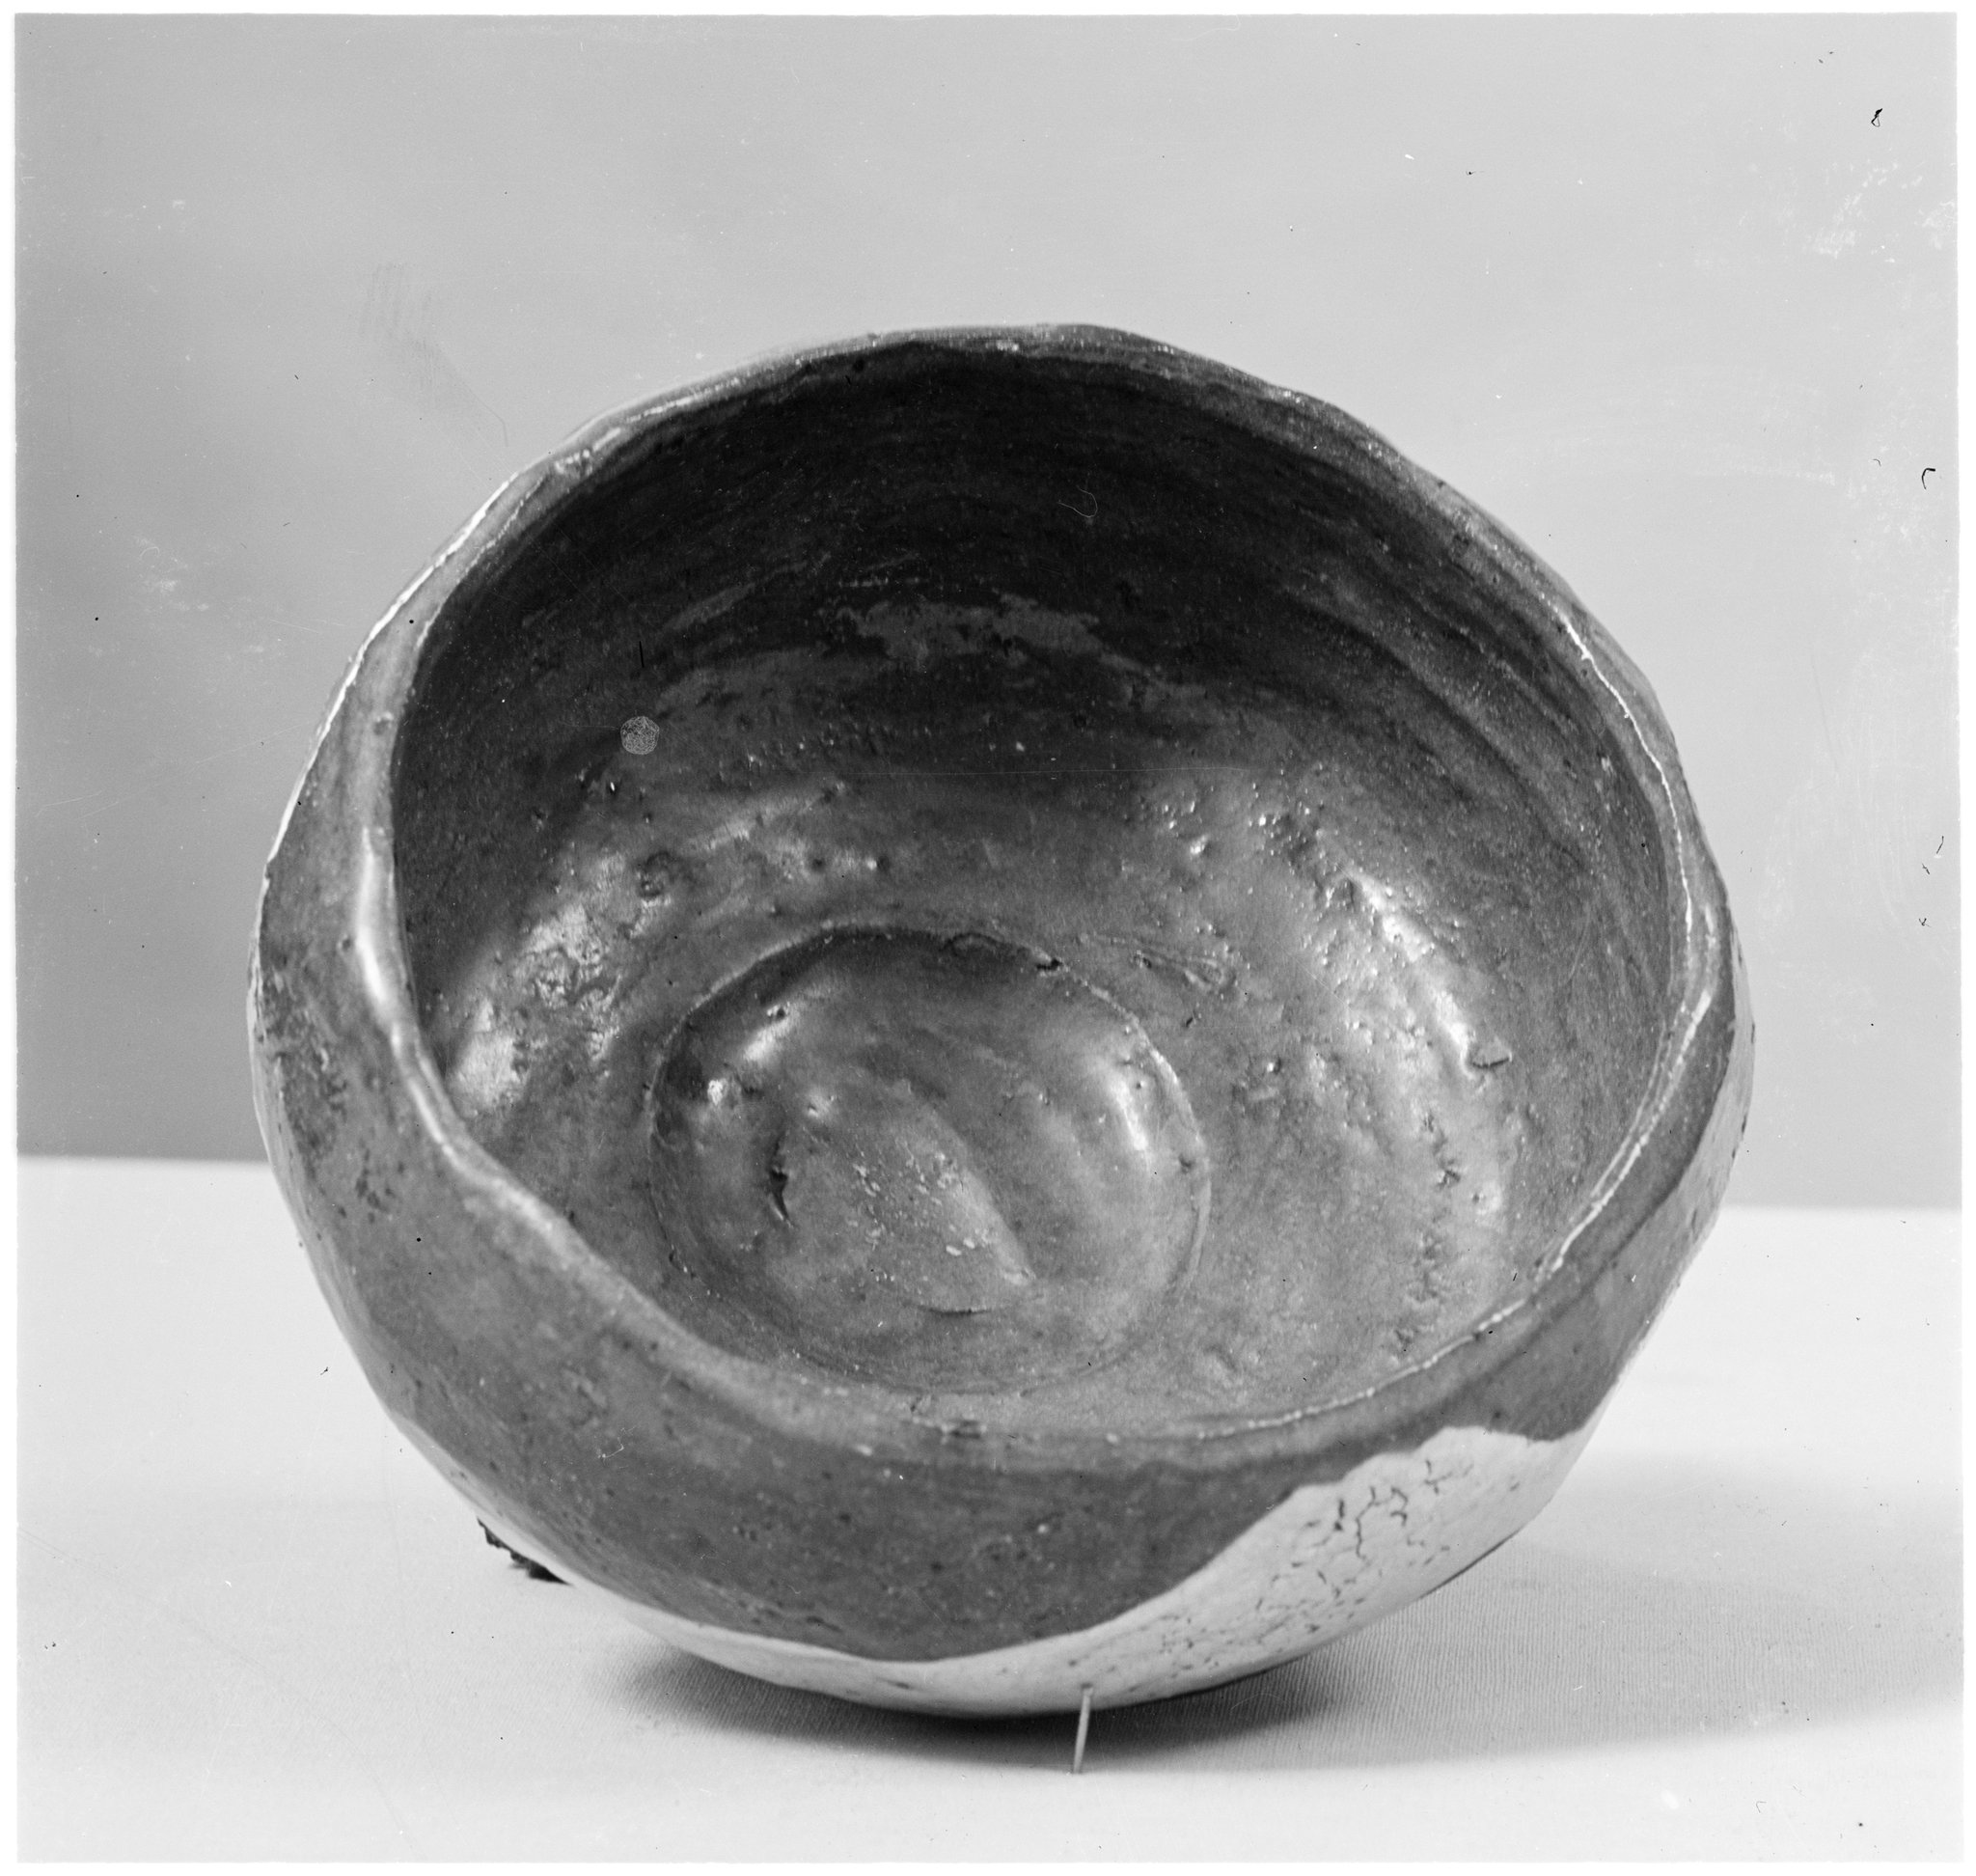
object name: teabowl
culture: japanese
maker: hogen doshun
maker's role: artist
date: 1868-1912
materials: clay, glaze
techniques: painting